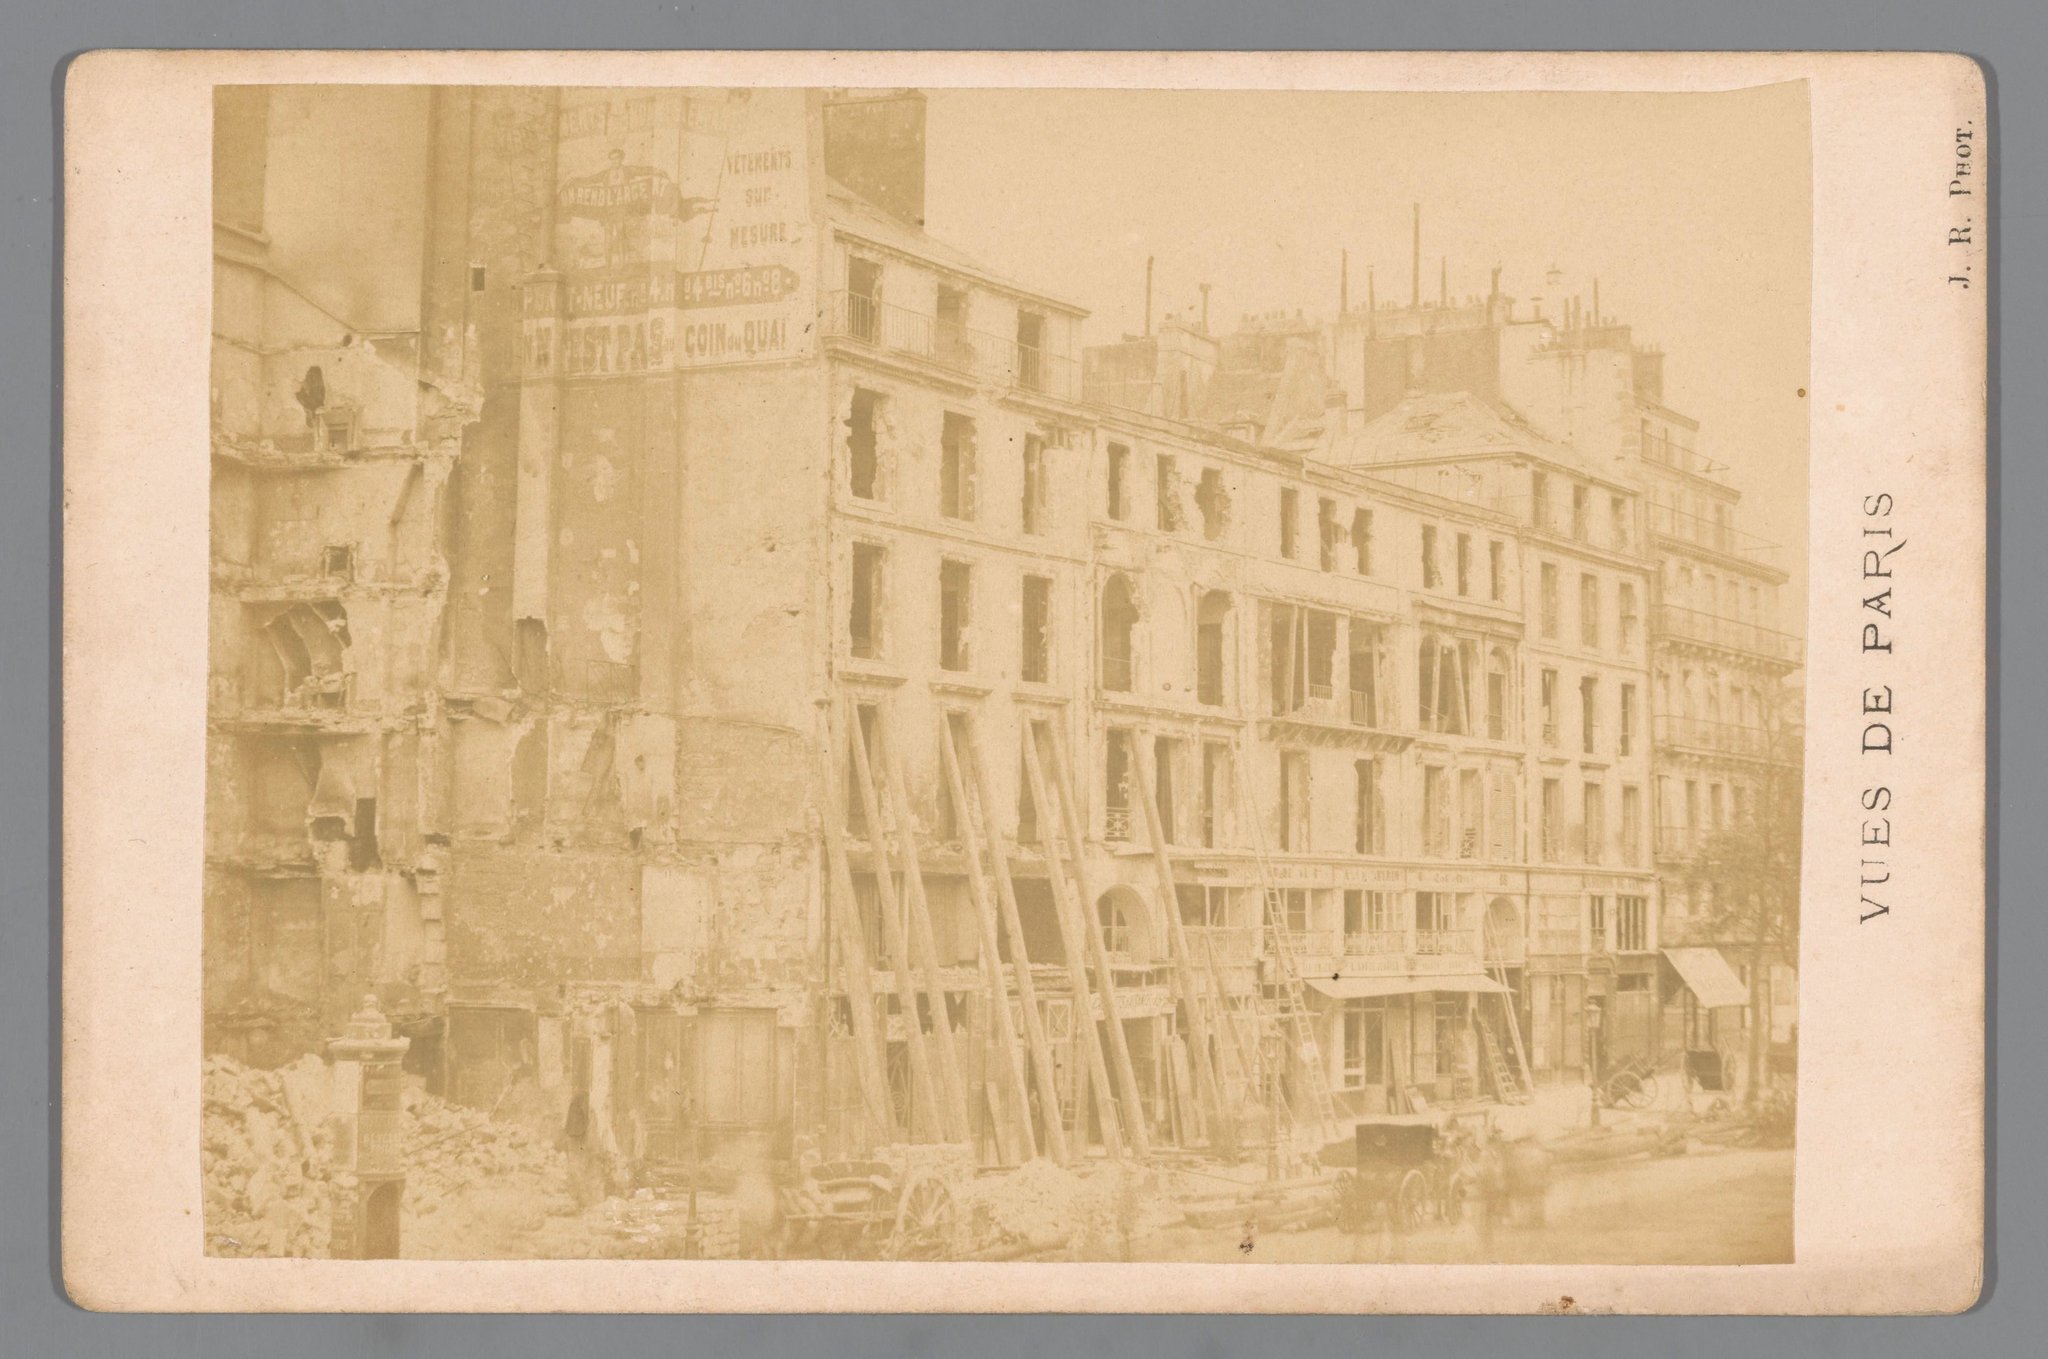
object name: photograph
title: Gezicht op de Rue Royale in Parijs na de brand door de Commune van Parijs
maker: jr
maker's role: fotograaf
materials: cardboard, photographic support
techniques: albumen print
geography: paris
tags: ruin of a building ~ architecture, street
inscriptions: annotation: ‘rue royale’